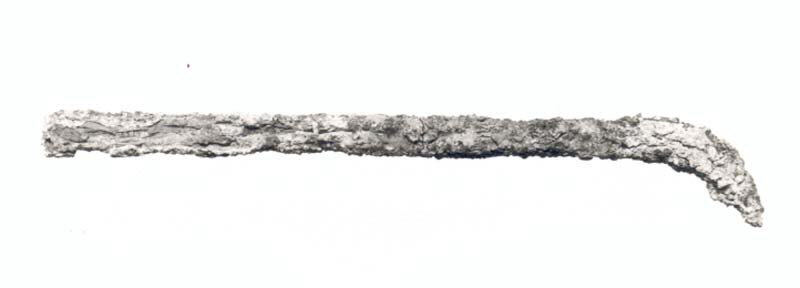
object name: musical instrument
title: Instrument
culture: sasanian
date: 201-700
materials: iron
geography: iran